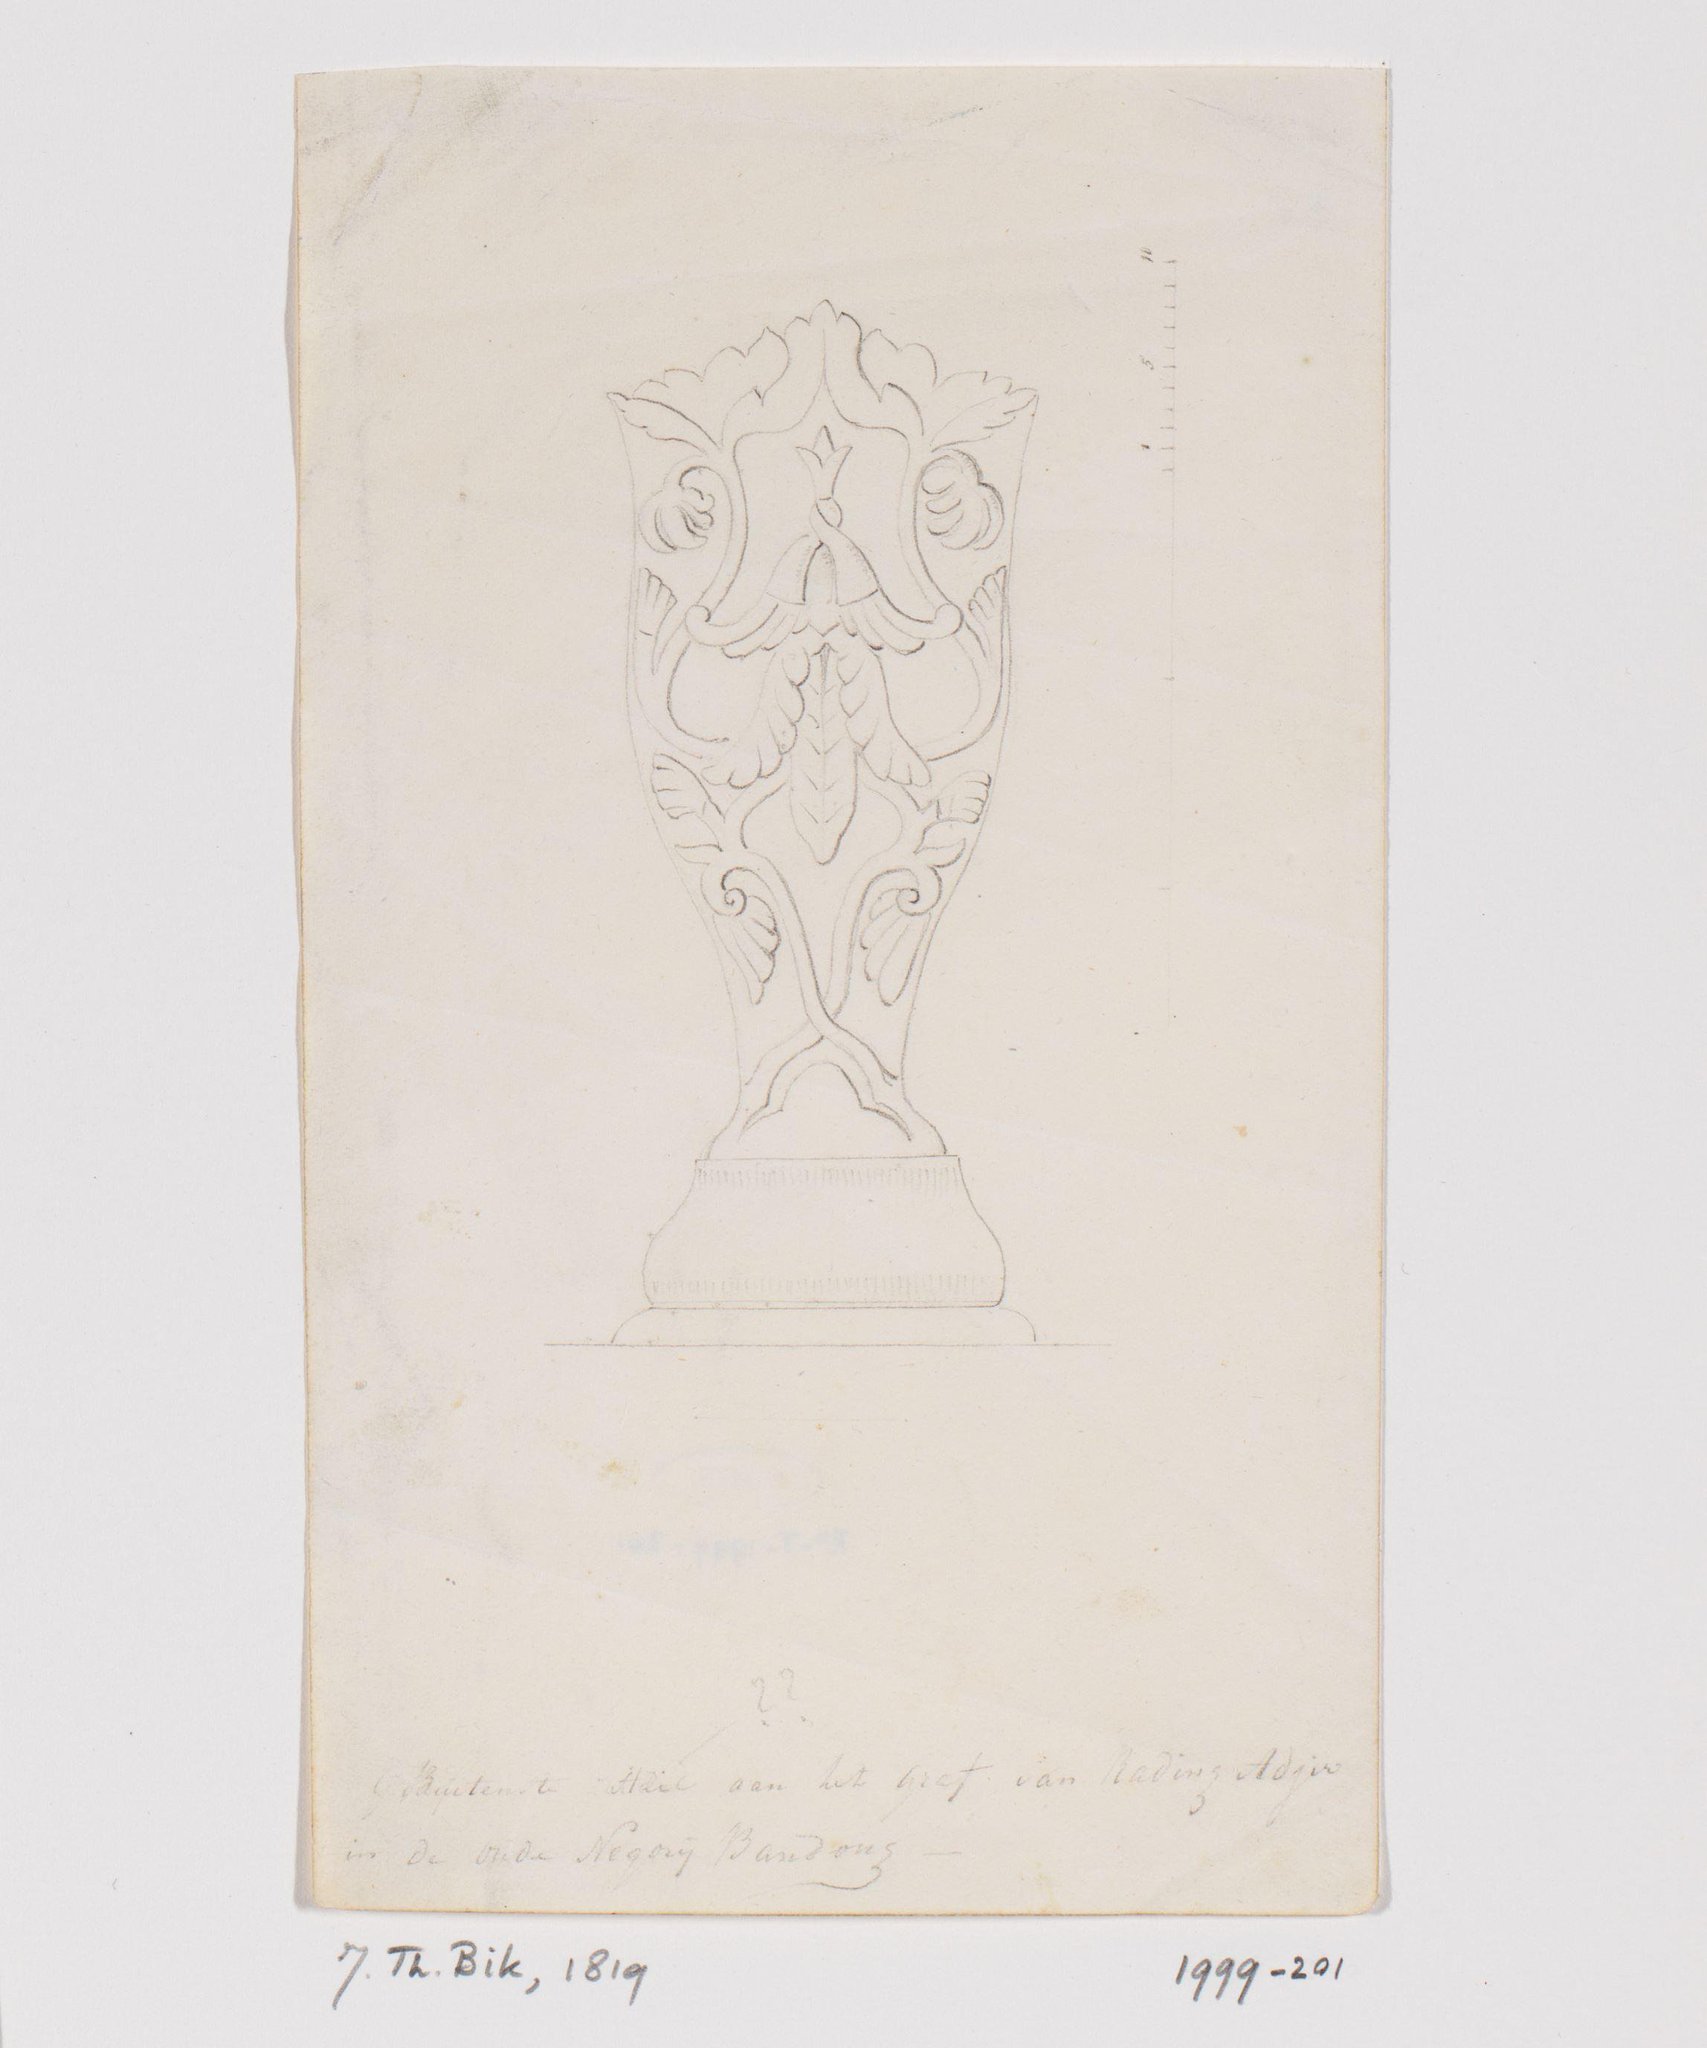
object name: topographical view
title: Detail van een islamitisch vorstelijk graf bij Banjaran, Priangan, West-Java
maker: jannes theodorus bik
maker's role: draughtsman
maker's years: 1796-1872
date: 1819-1824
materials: paper, pencil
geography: west java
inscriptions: annotation: ‘Buitenste steil van het graf van Rading Adjir in de oude Negorij Bandong’